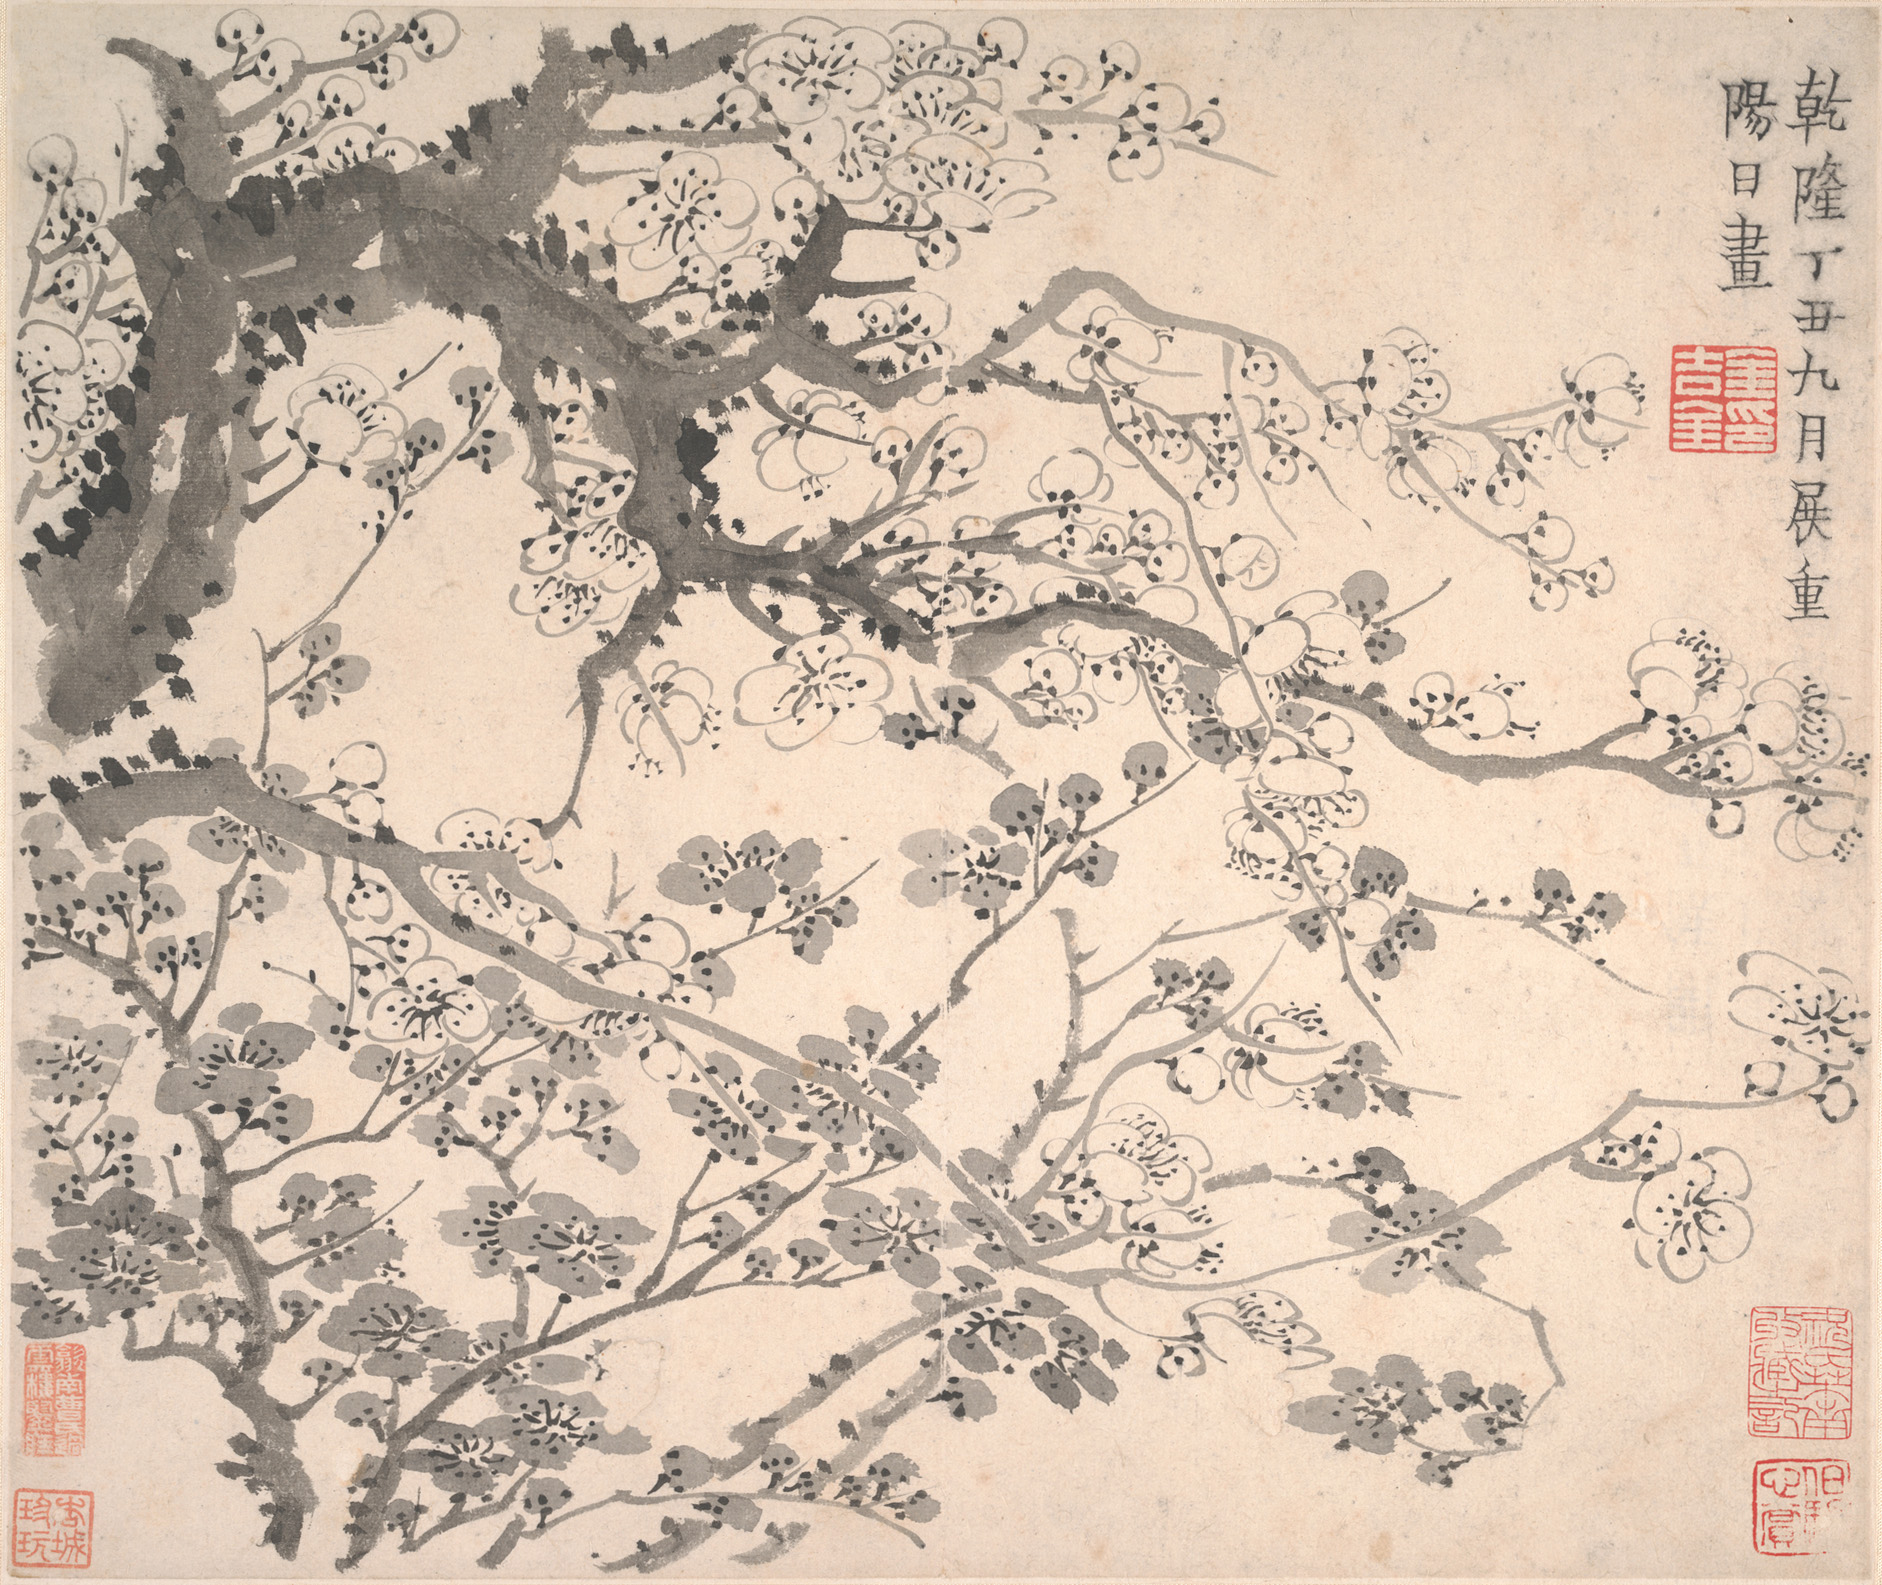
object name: album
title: Plum blossoms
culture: chinese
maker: jin nong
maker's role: artist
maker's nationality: chinese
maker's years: 1687-1773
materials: ink, paper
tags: flowers,trees